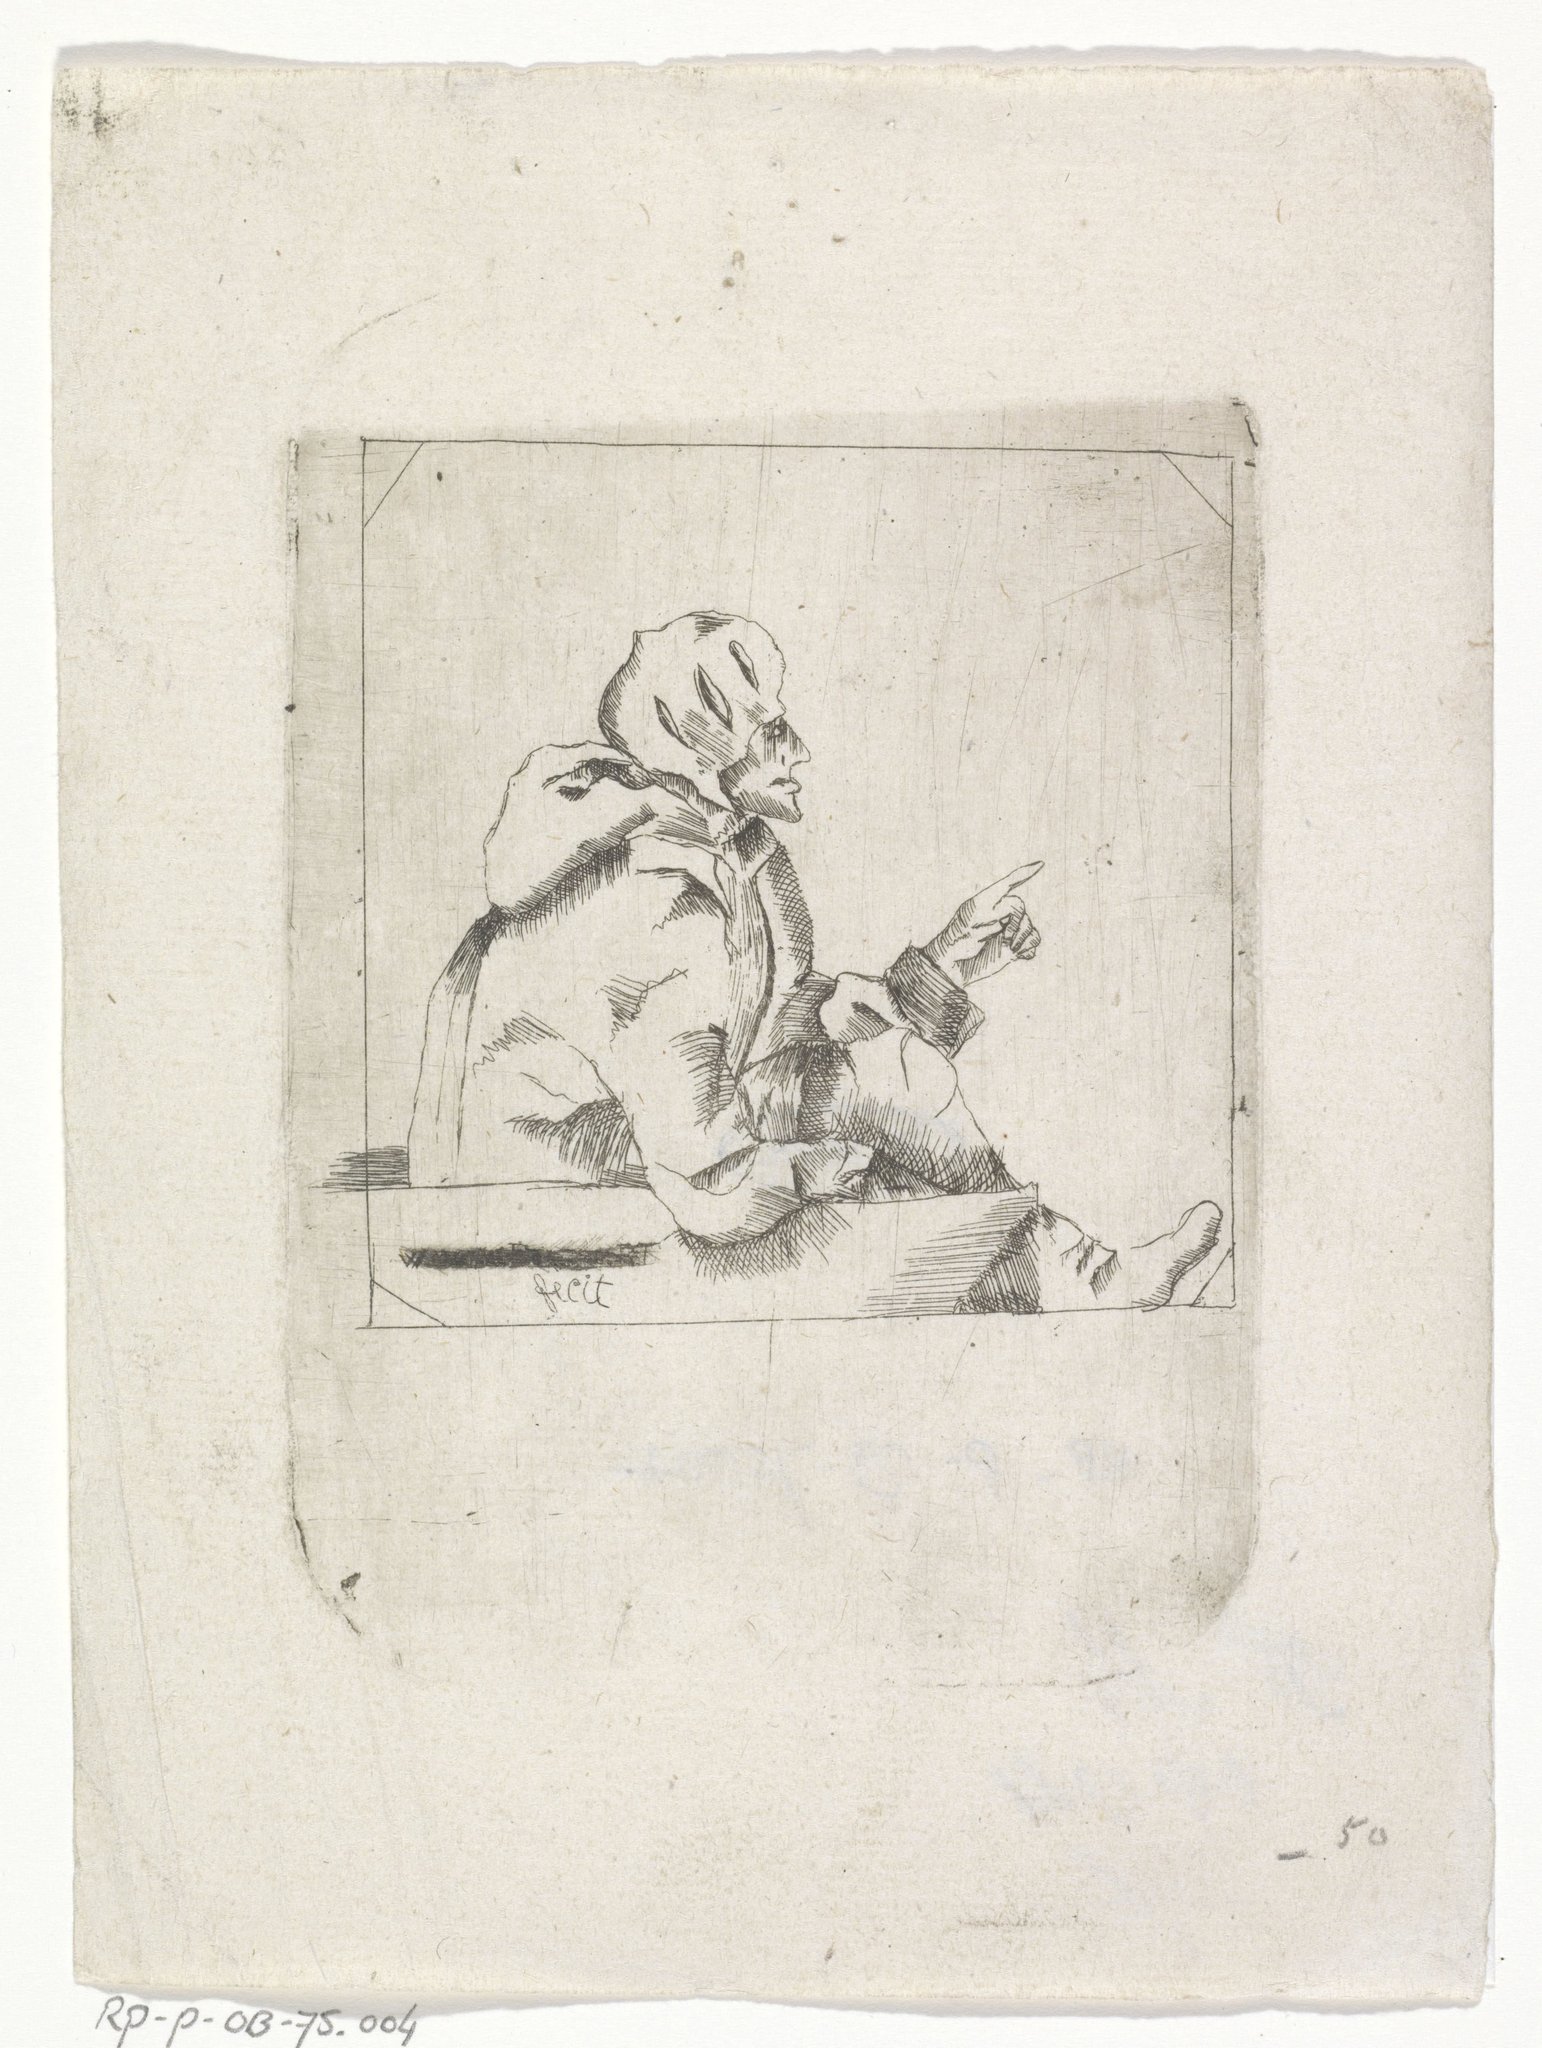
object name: print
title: Zittende naar rechts wijzende figuur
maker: Anonymous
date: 1700-1900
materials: paper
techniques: etching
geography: netherlands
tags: sitting figure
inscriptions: collector's mark: Lugt 2228, inscription: ‘FM 1884’